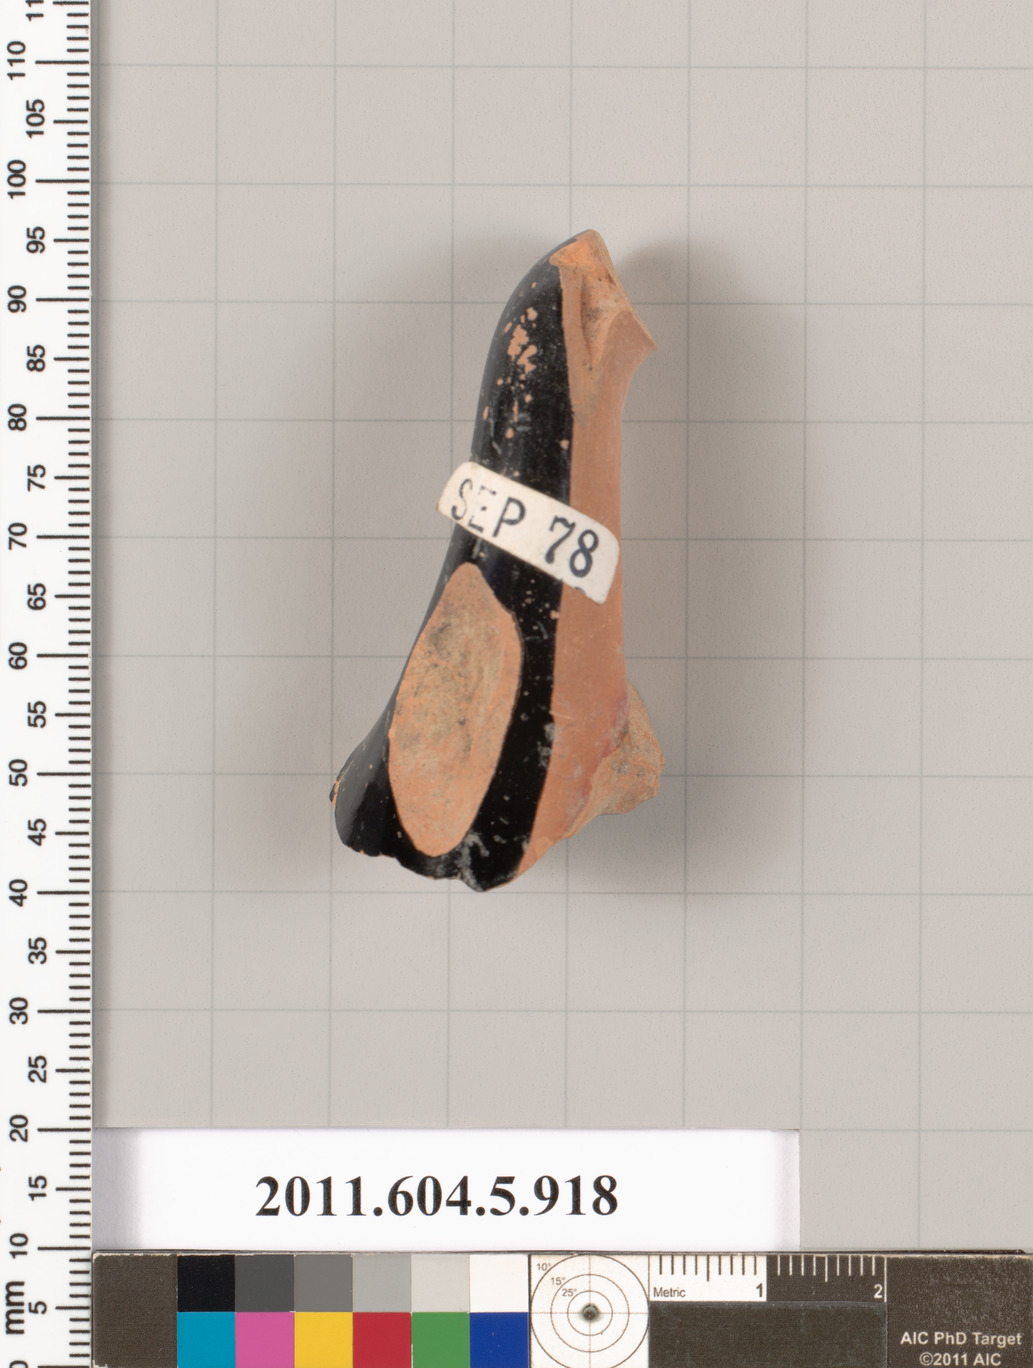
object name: kylix fragment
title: Terracotta fragment of a kylix (drinking cup)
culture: greek, attic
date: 600-401 BCE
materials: terracotta